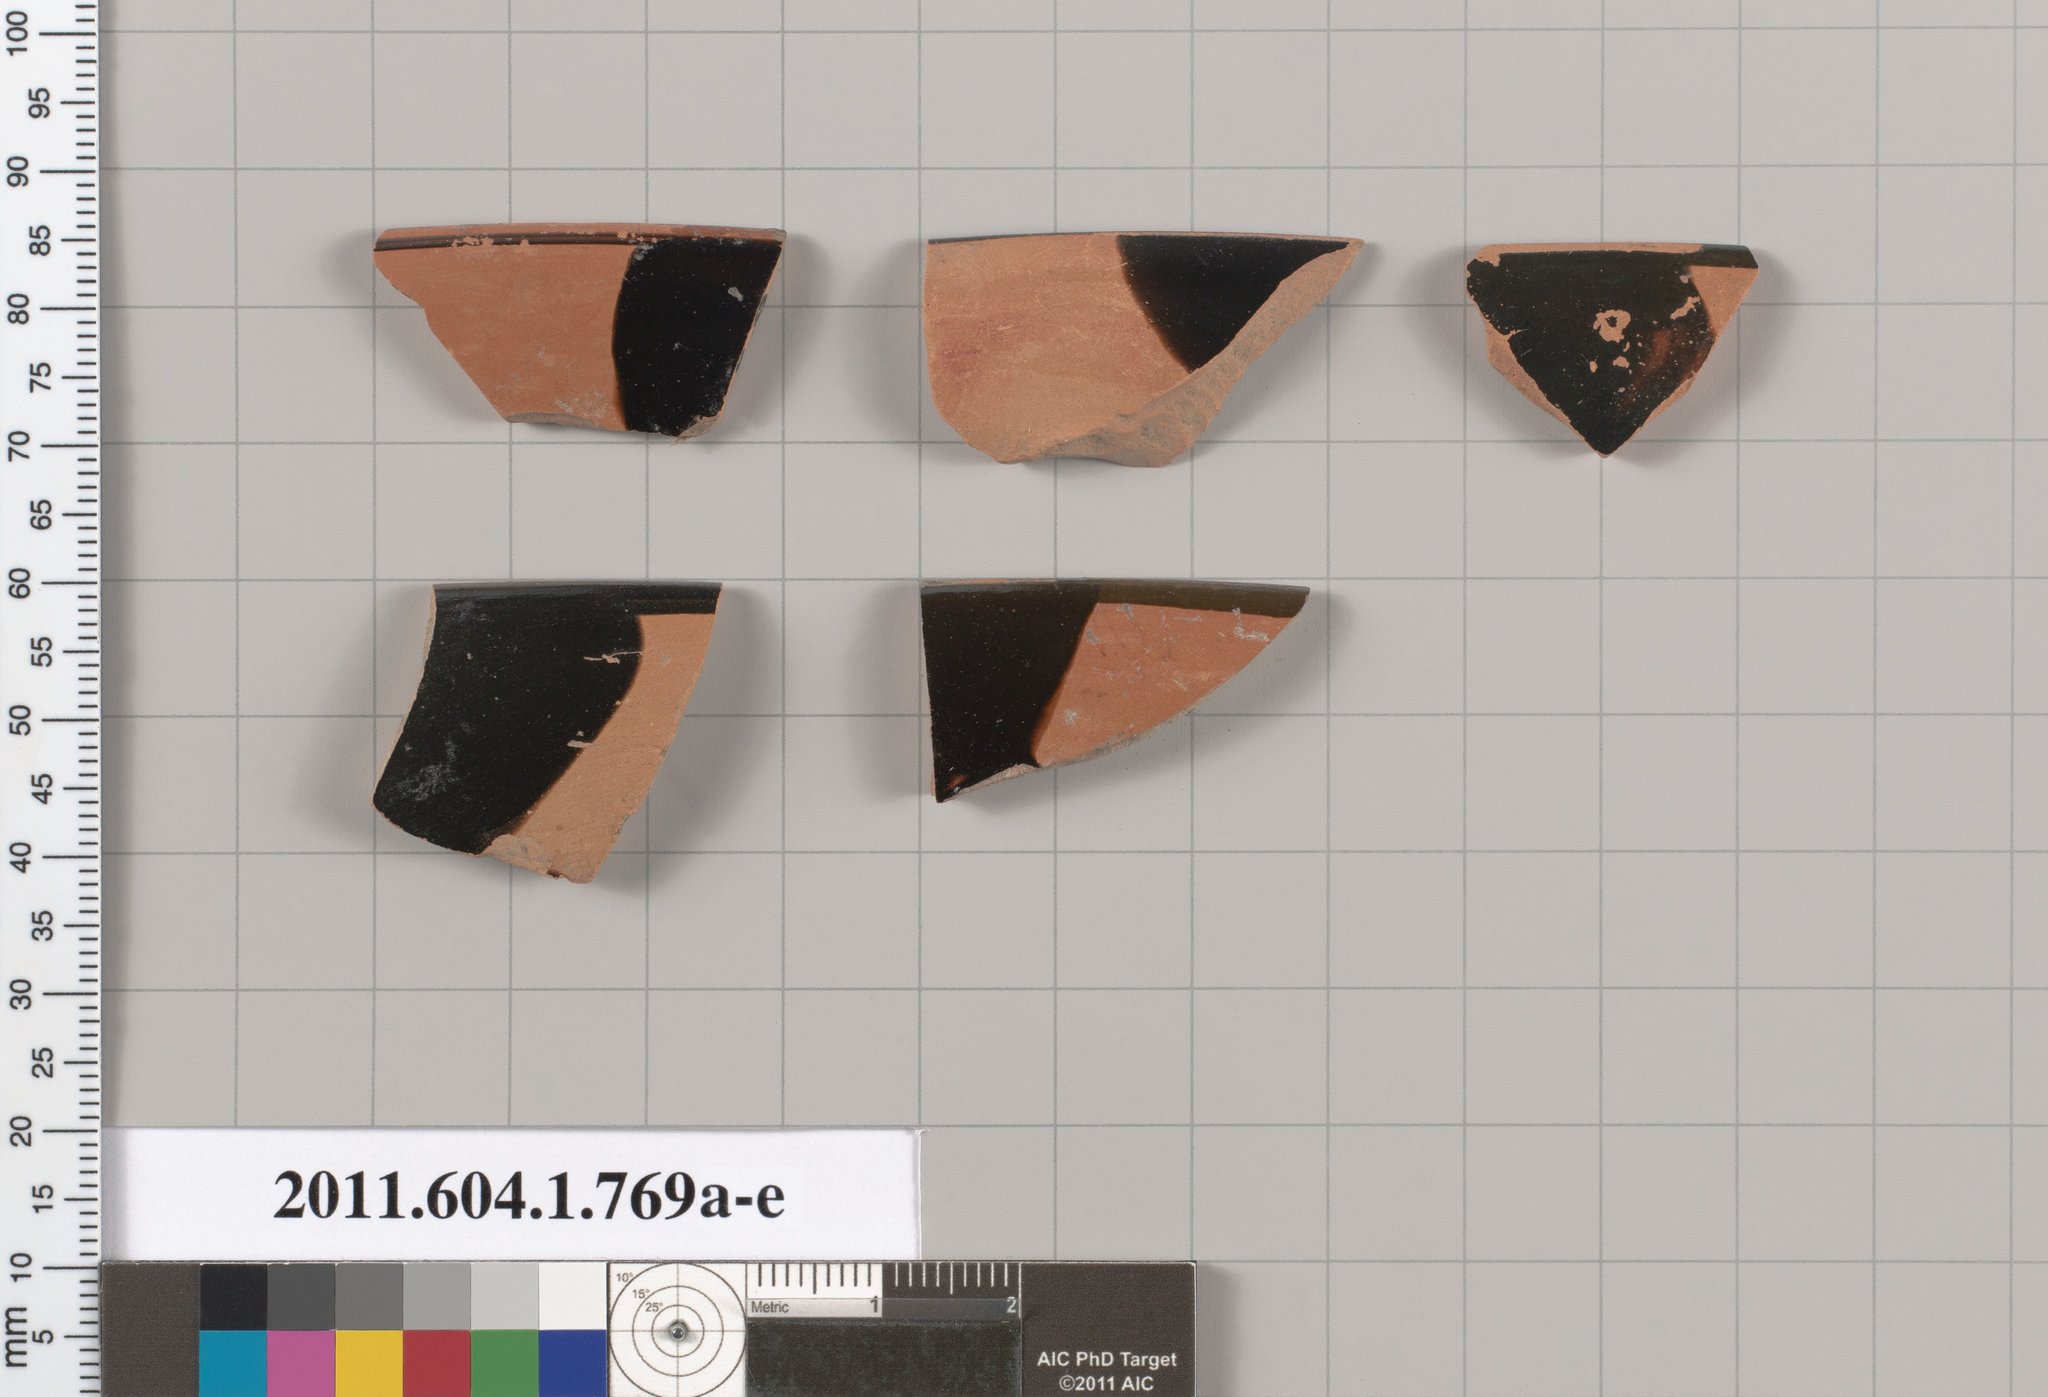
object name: kylix fragment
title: Terracotta rim fragments of kylikes (drinking cups)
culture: greek, attic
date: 500-401 BCE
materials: terracotta